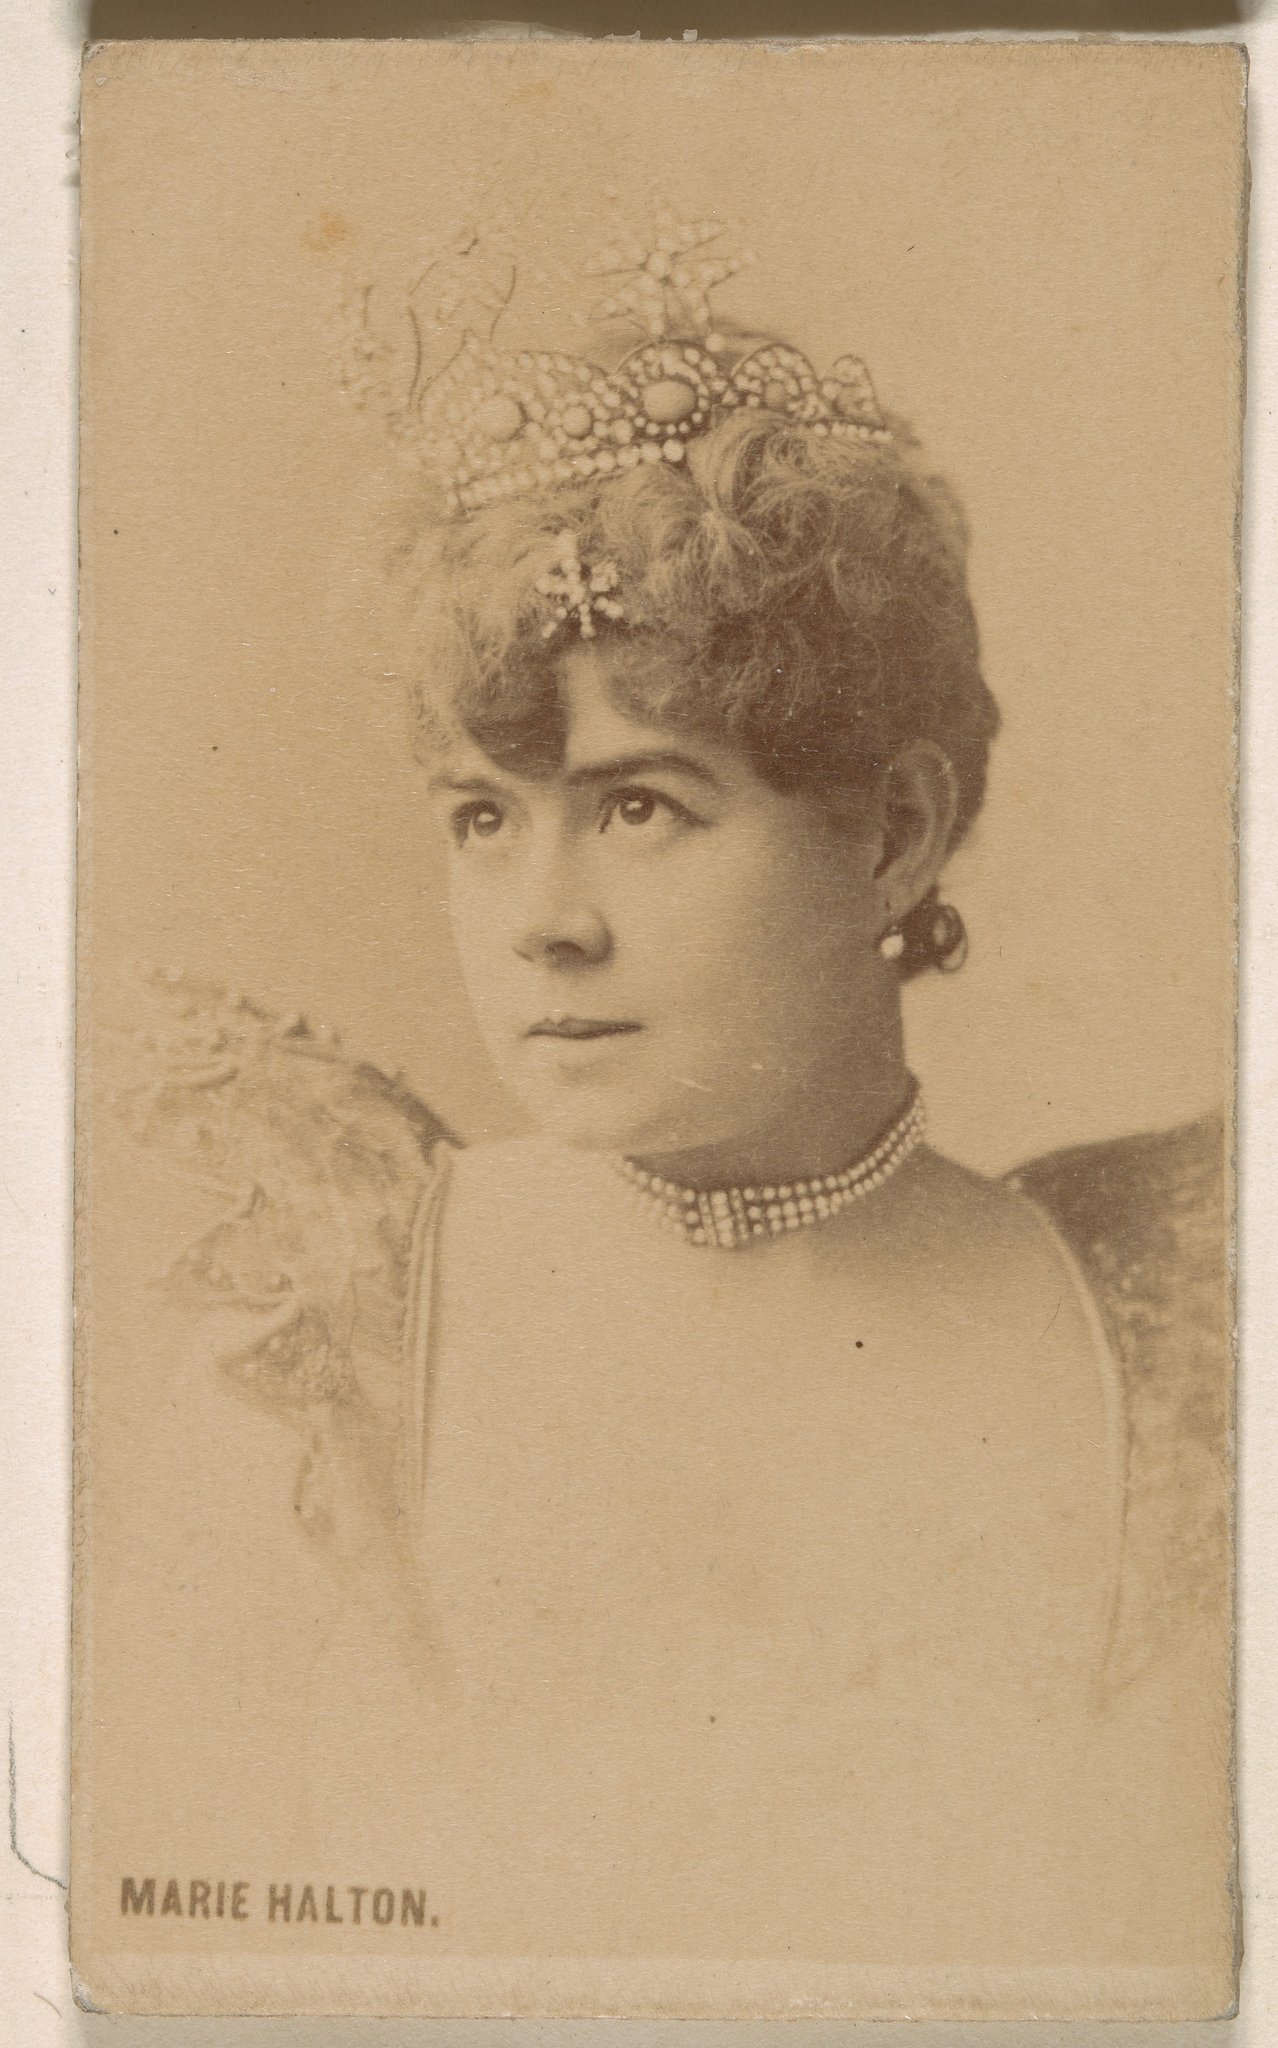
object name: photograph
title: Marie Halton, from the Actresses series (N246), Type 1, issued by Kinney Brothers to promote Sporting Extra Cigarettes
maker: kinney brothers tobacco company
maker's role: publisher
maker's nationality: american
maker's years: 1869-2011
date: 1890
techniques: albumen silver print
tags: portraits,women,actresses